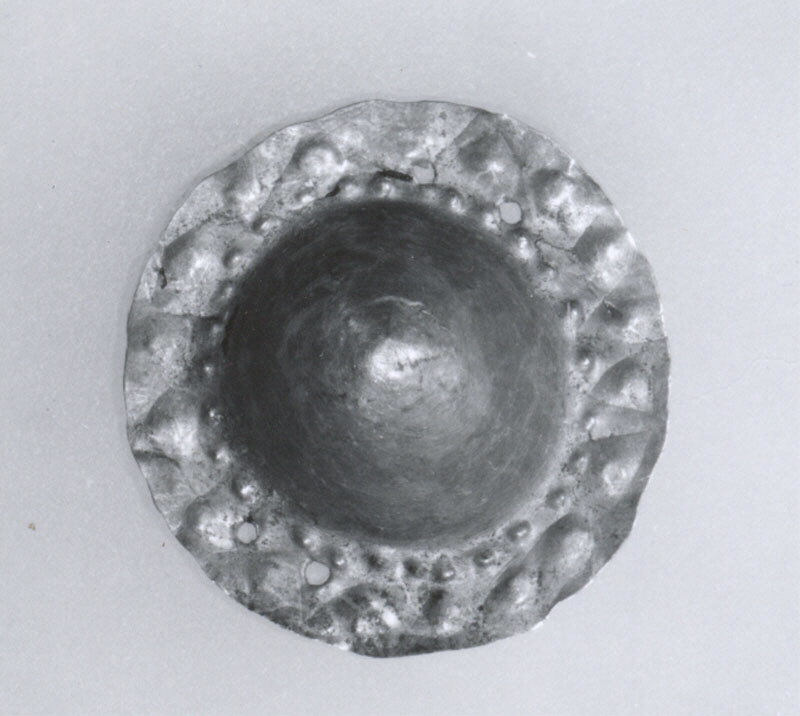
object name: bos or appliqué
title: Boss or appliqué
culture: iranian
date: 1-1000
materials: gold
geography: iran